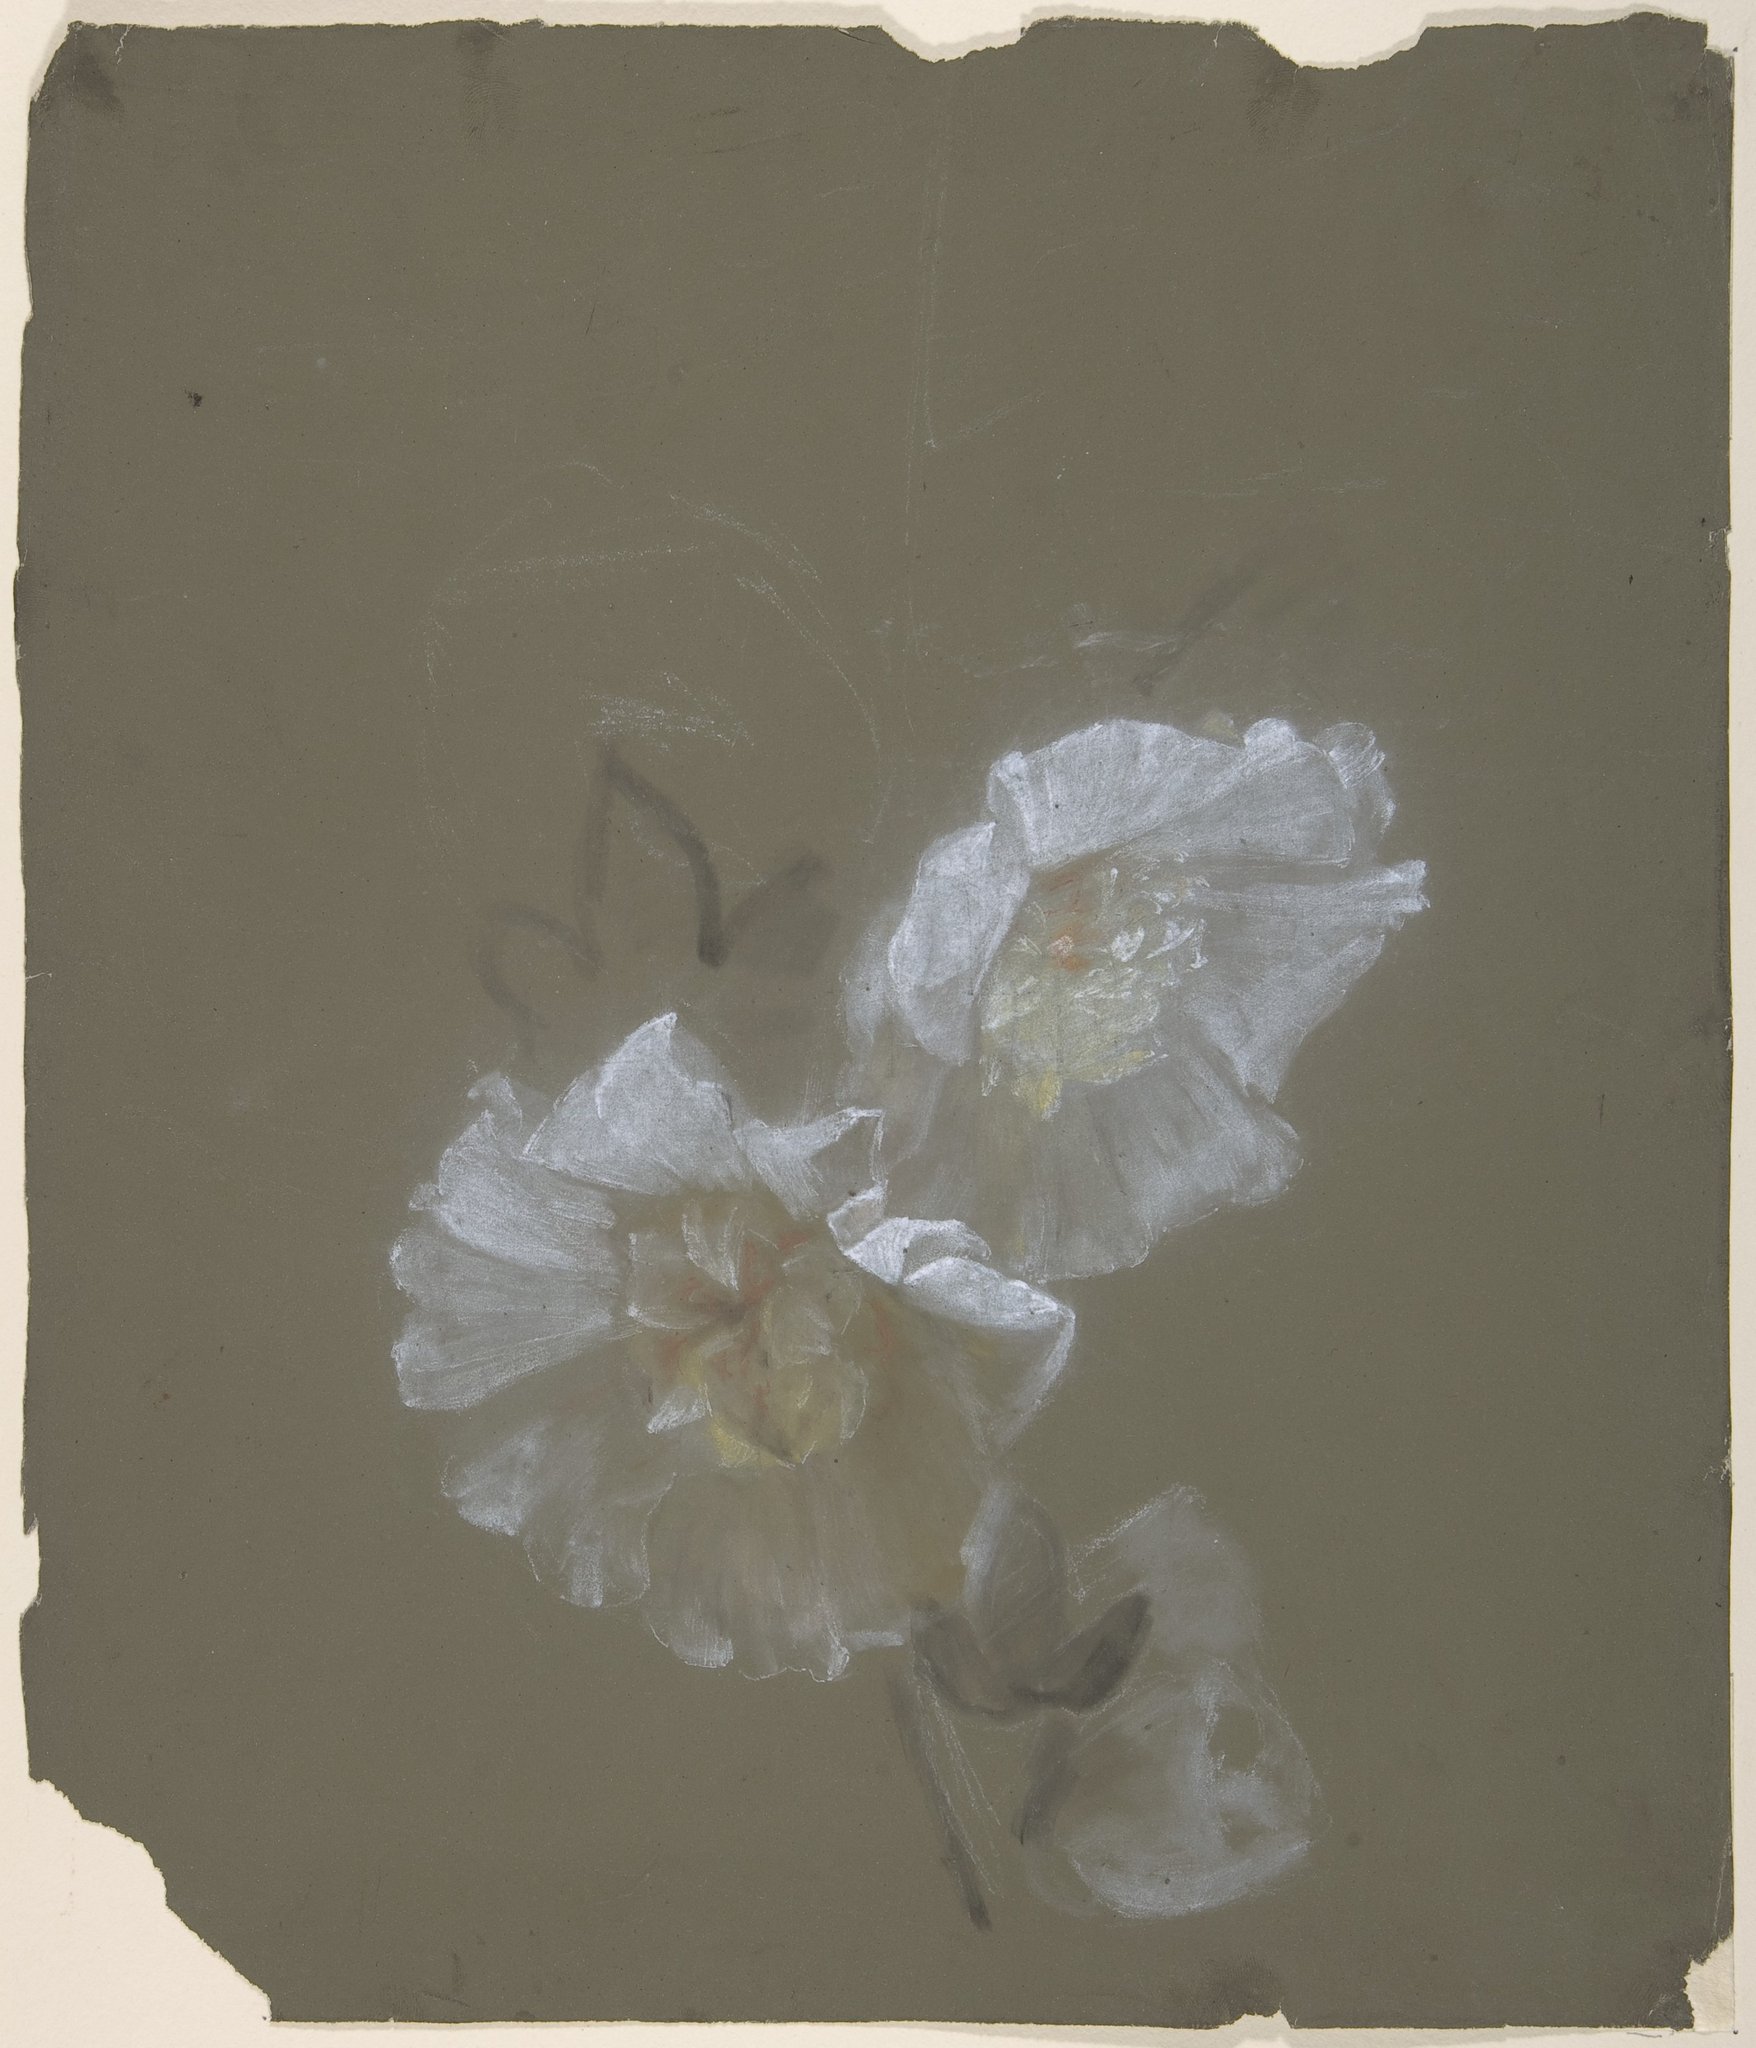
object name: drawing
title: Floral Design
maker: antoine berjon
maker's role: artist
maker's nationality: french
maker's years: 1754-1843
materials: chalk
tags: flowers